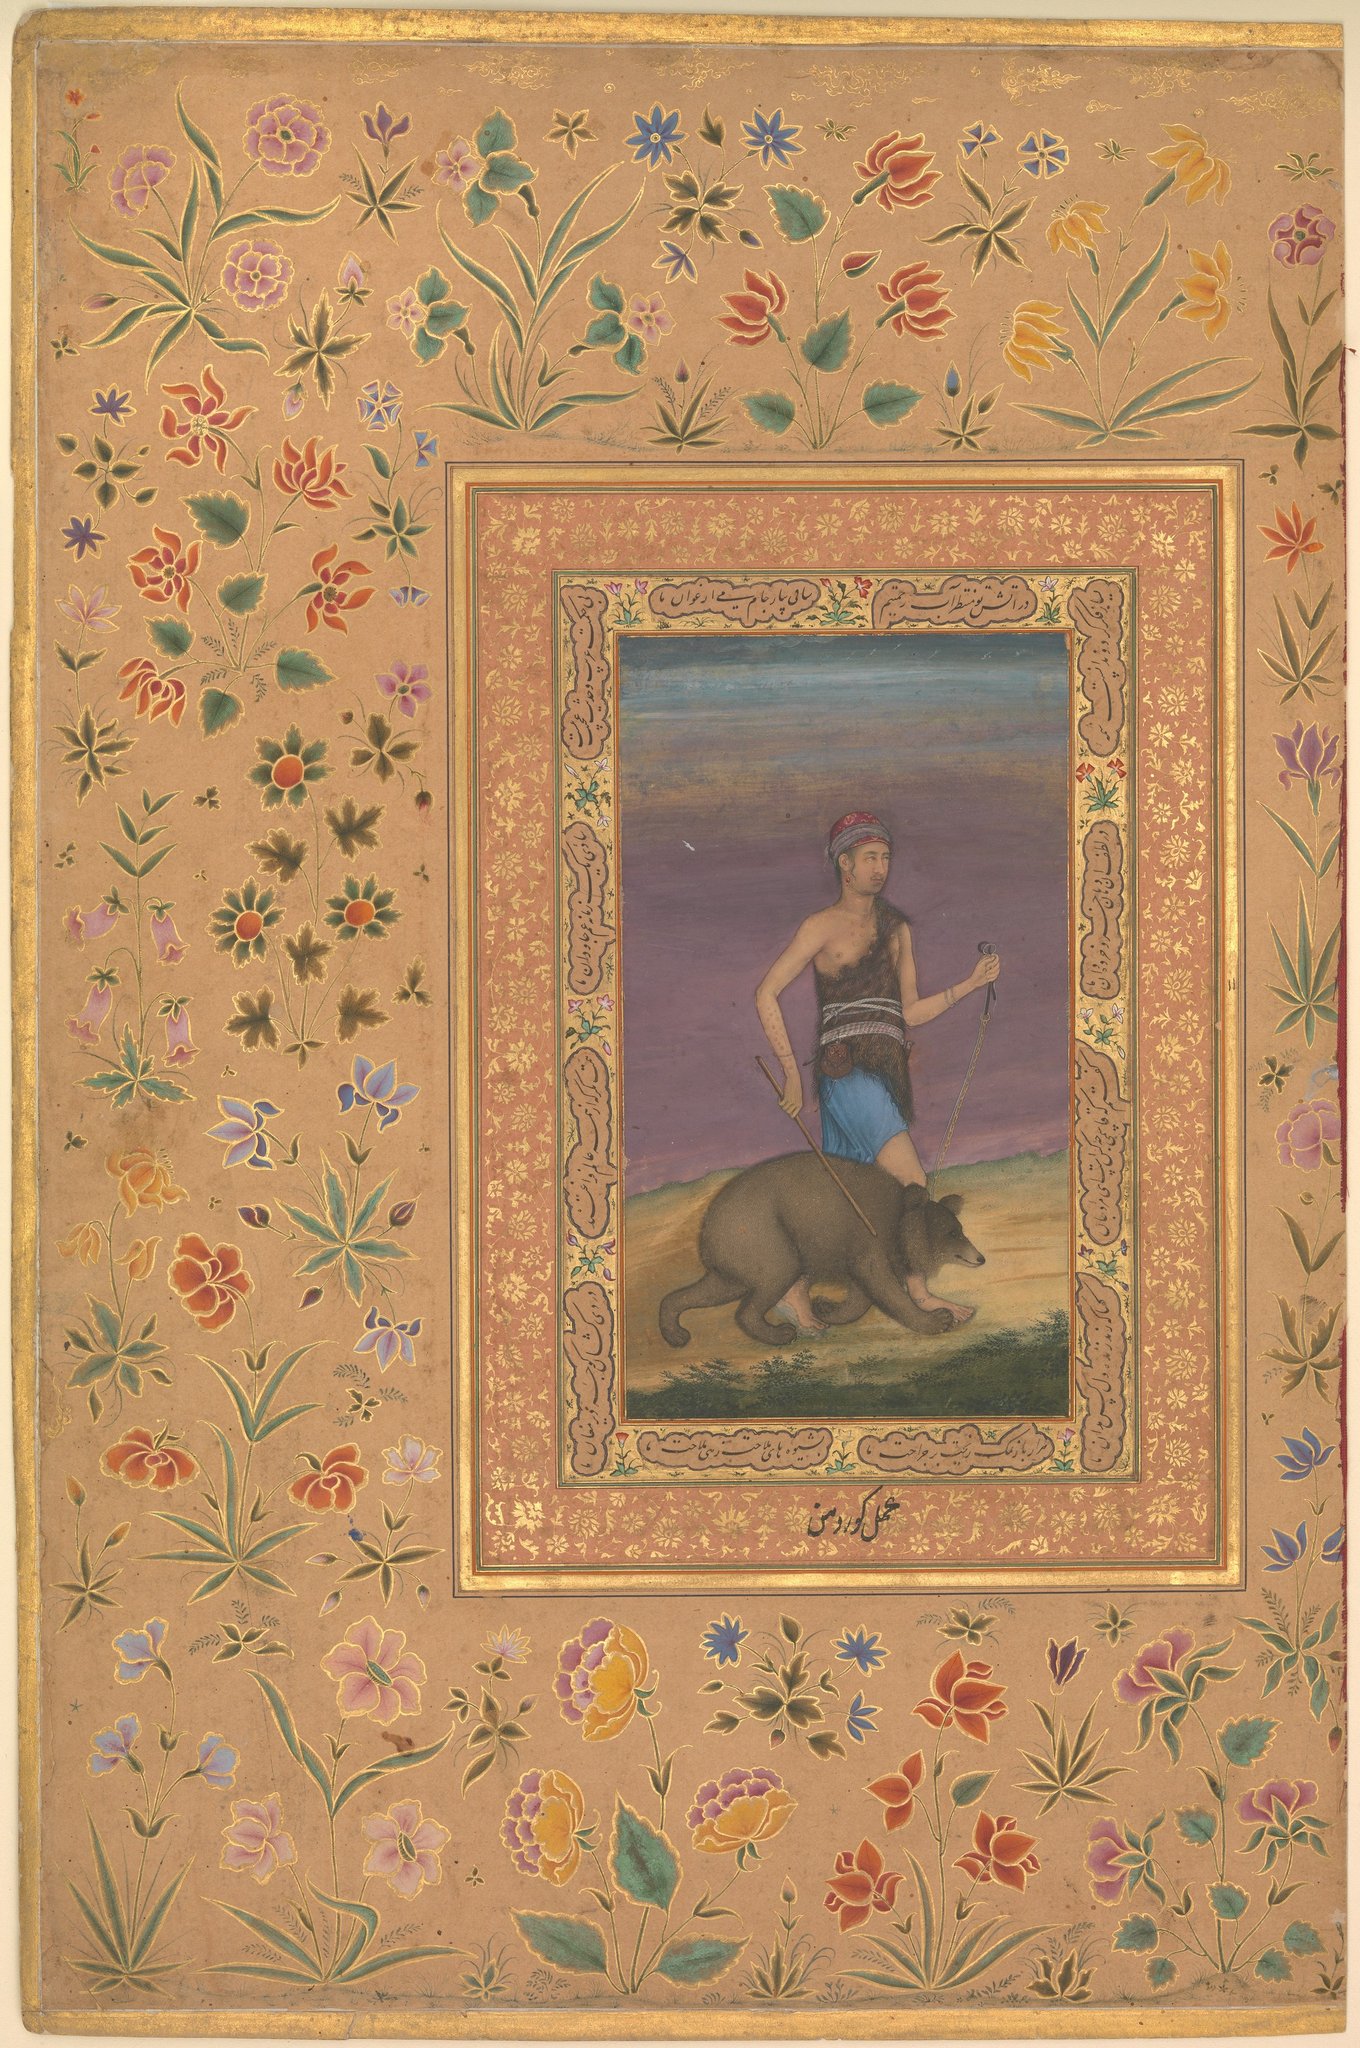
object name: album leaf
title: "Dervish Leading a Bear", Folio from the Shah Jahan Album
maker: govardhan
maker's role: artist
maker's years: 1596-1645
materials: gold, ink, paper, watercolor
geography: india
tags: bears,men